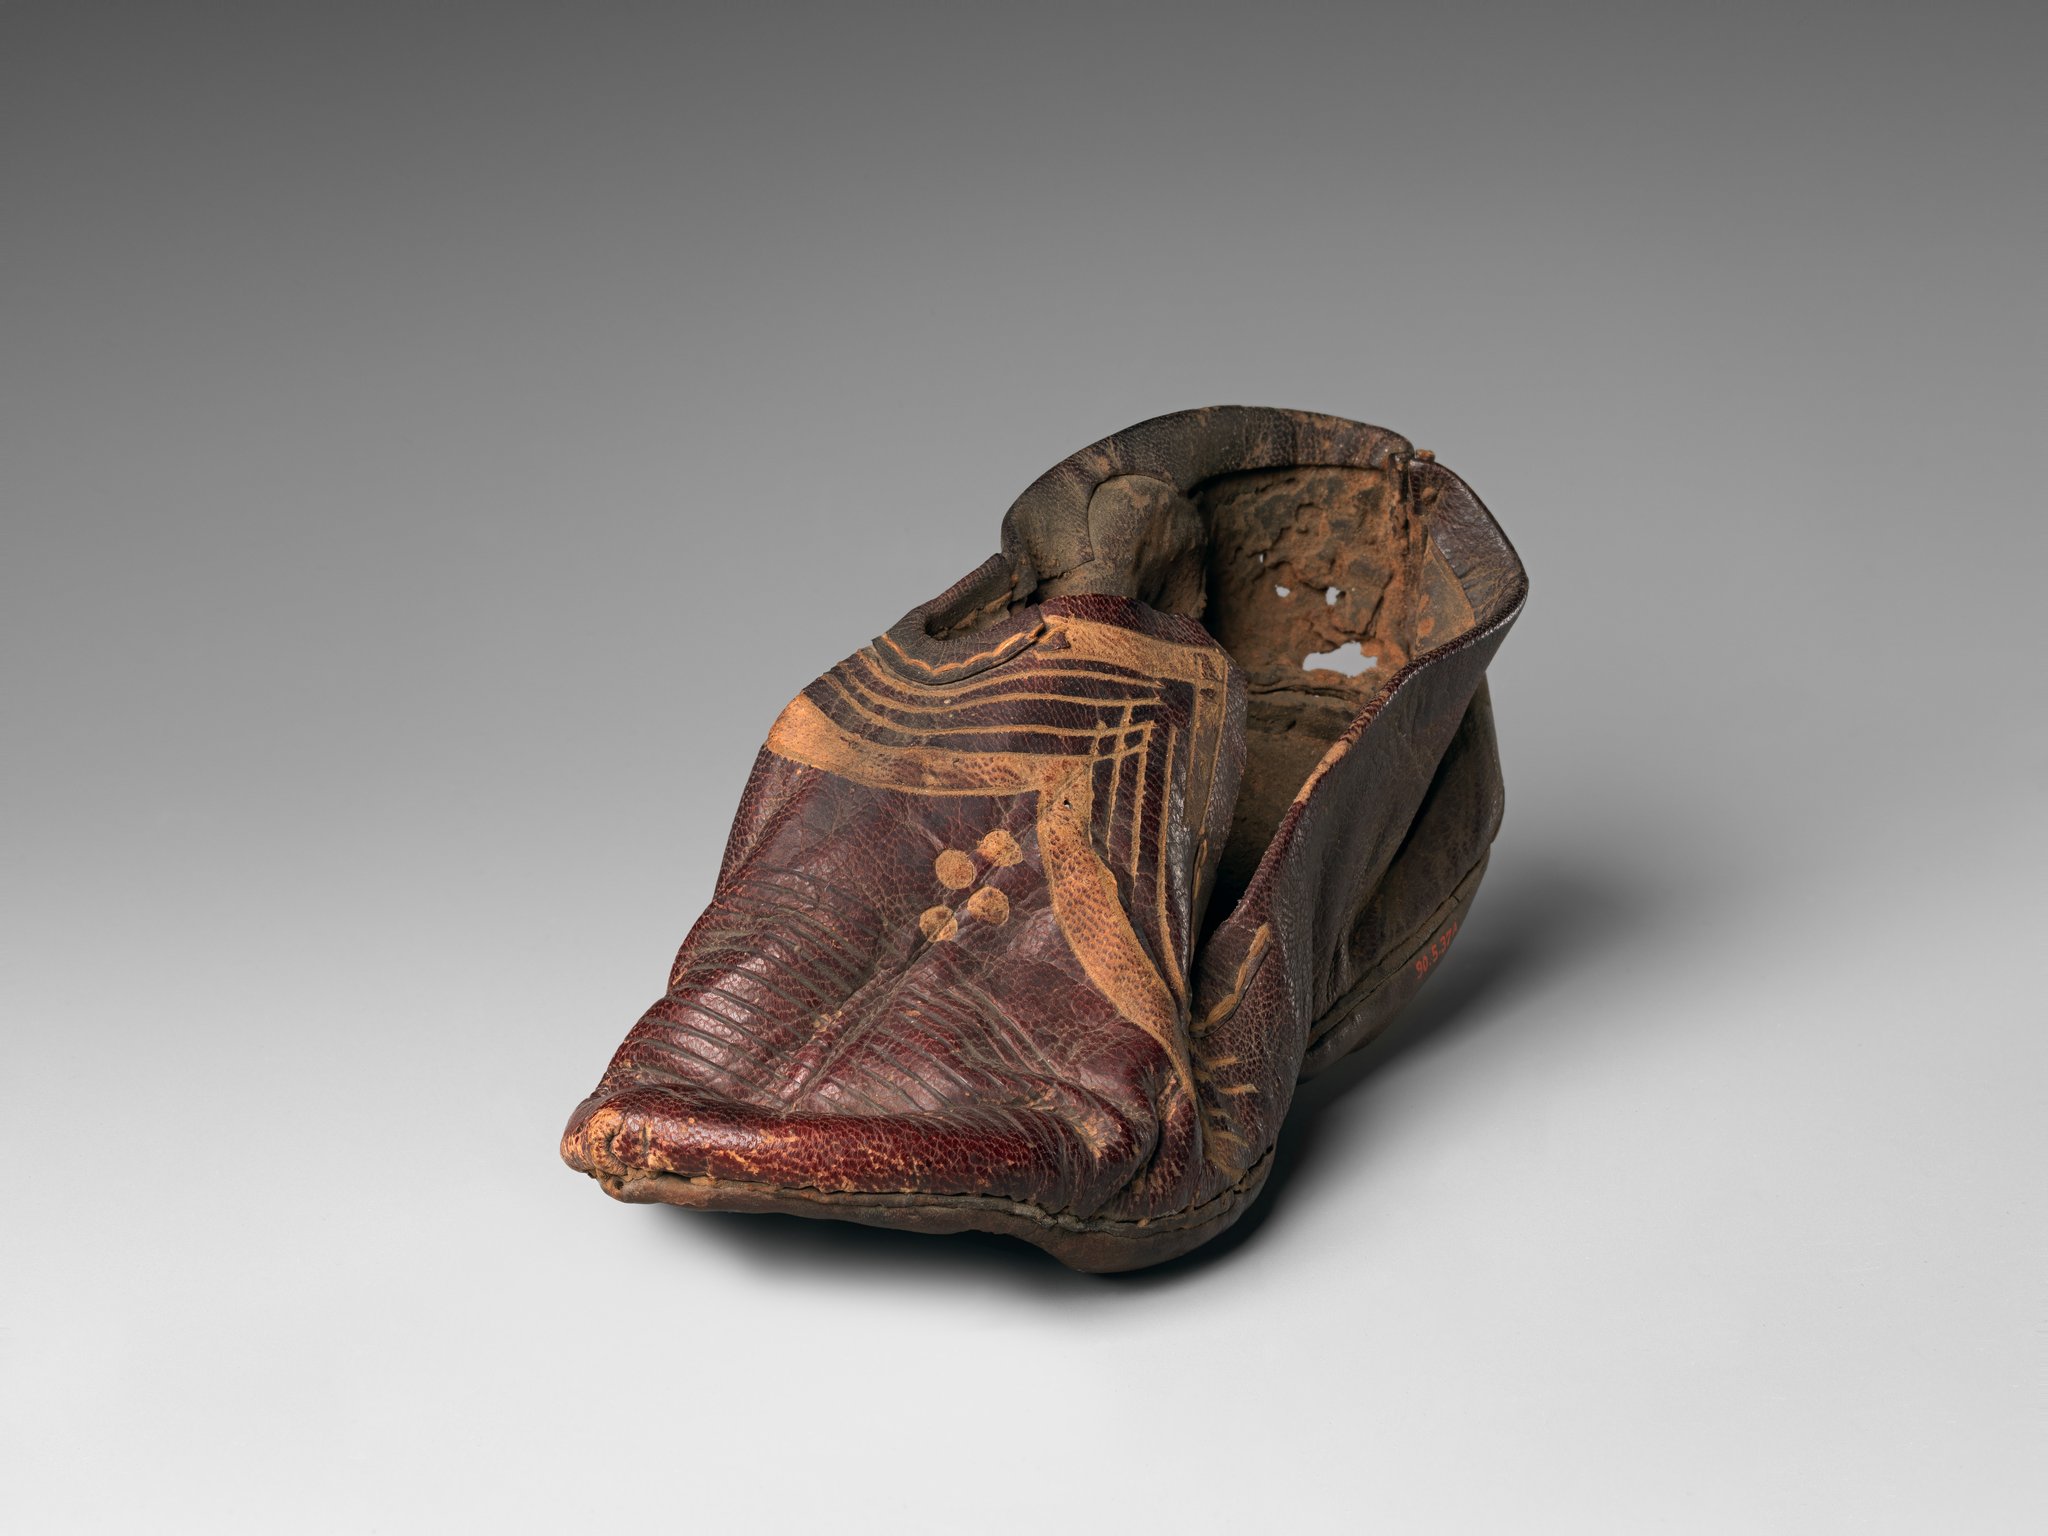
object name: slipper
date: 201-700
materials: leather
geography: egypt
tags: footwear